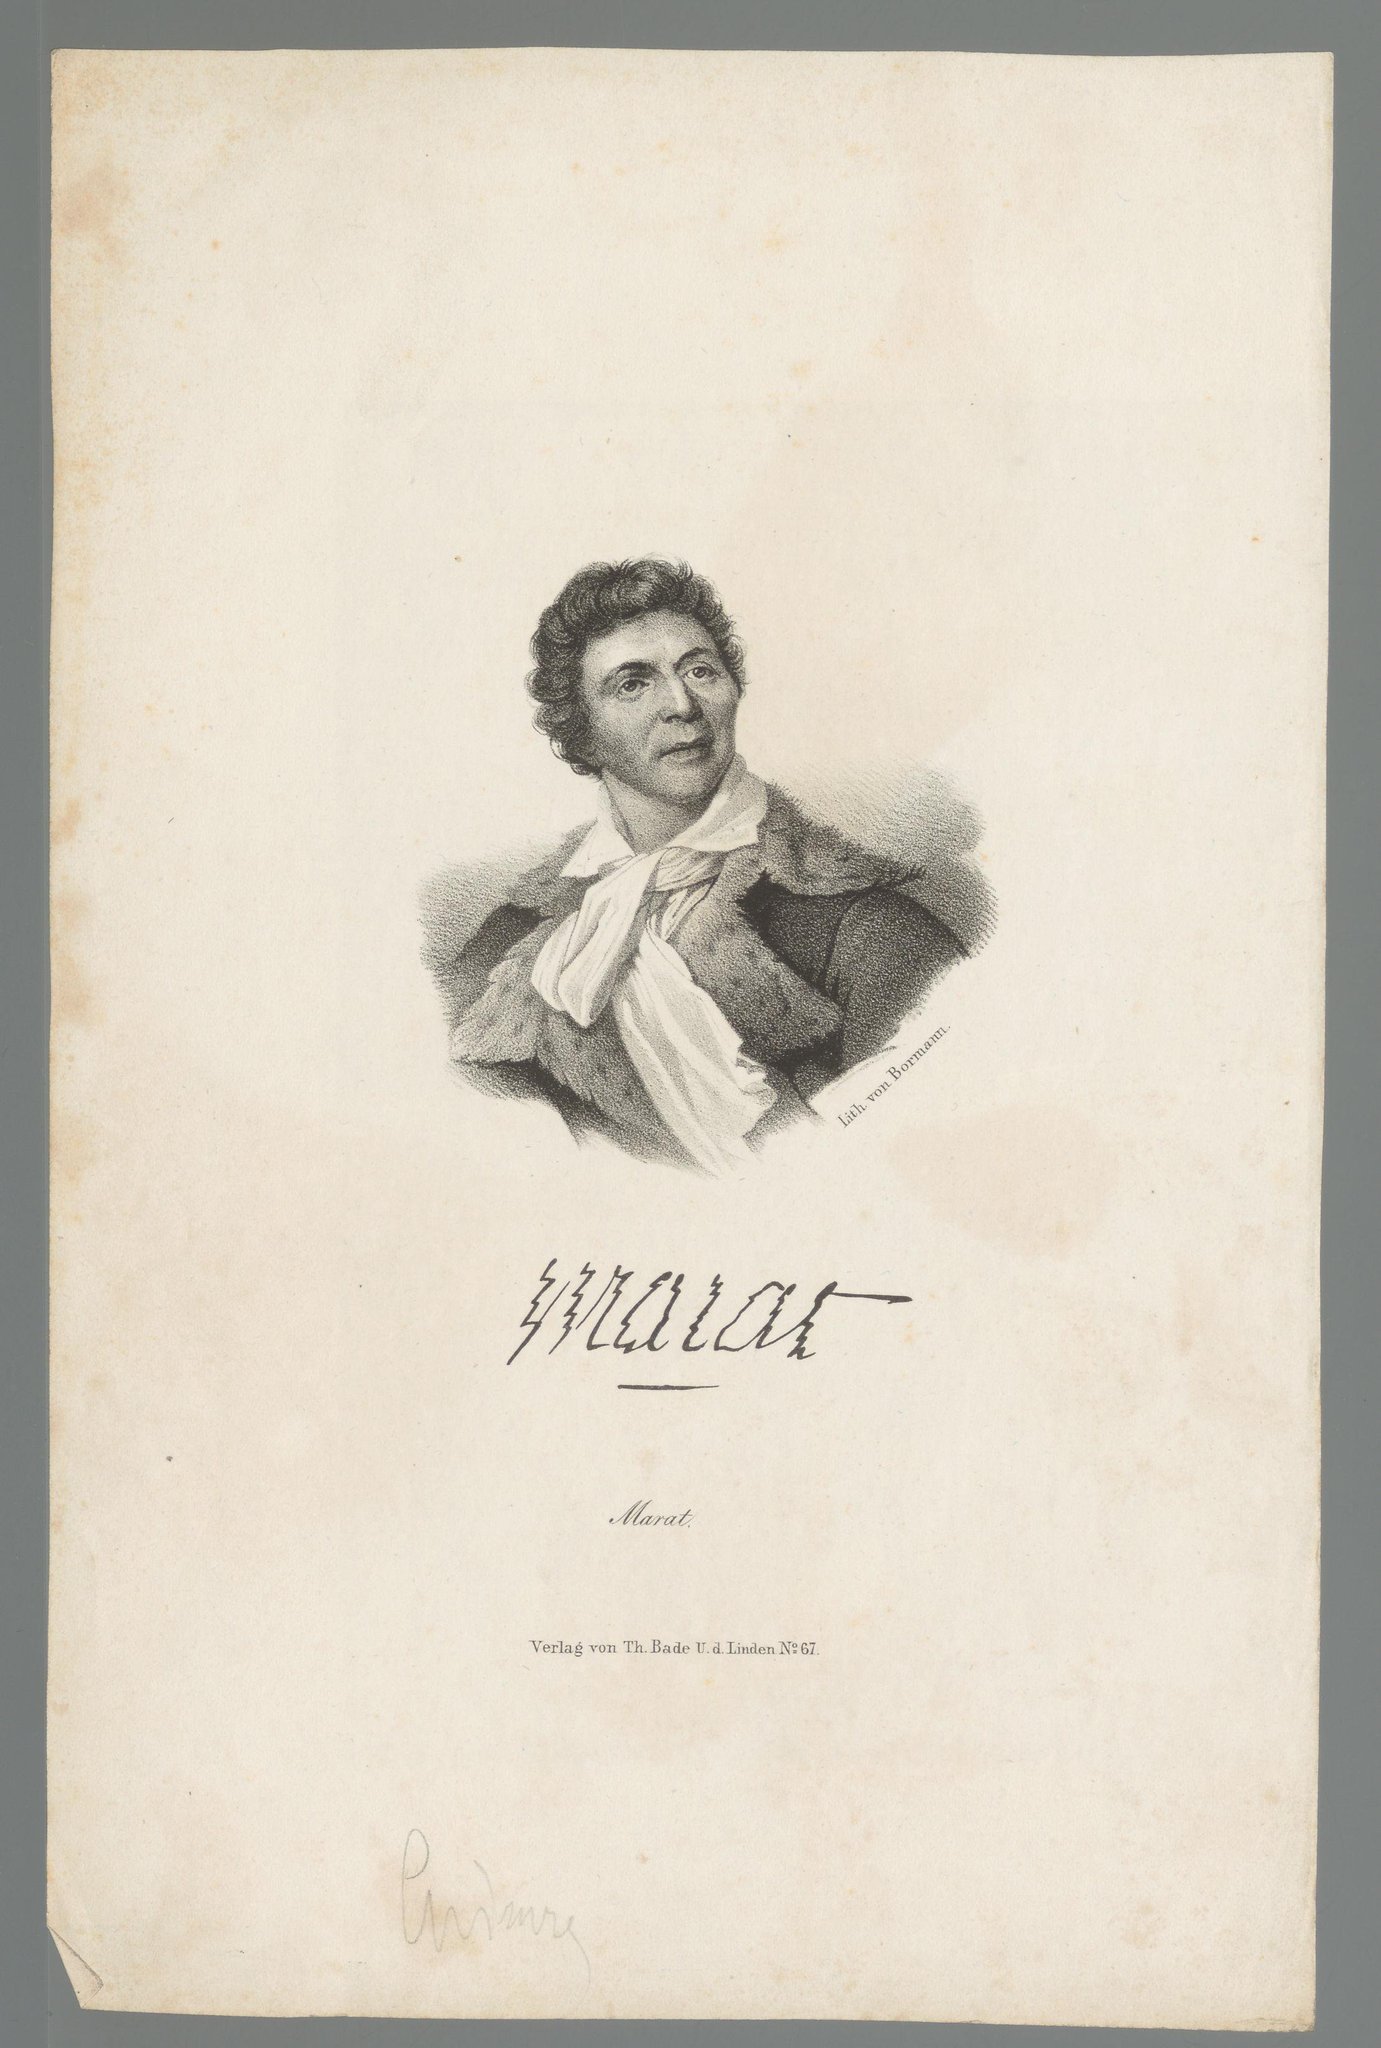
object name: print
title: Marat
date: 1825-1850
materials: paper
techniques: lithograph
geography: berlin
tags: paris, adult man, historical persons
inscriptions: collector's mark: Lugt 2228